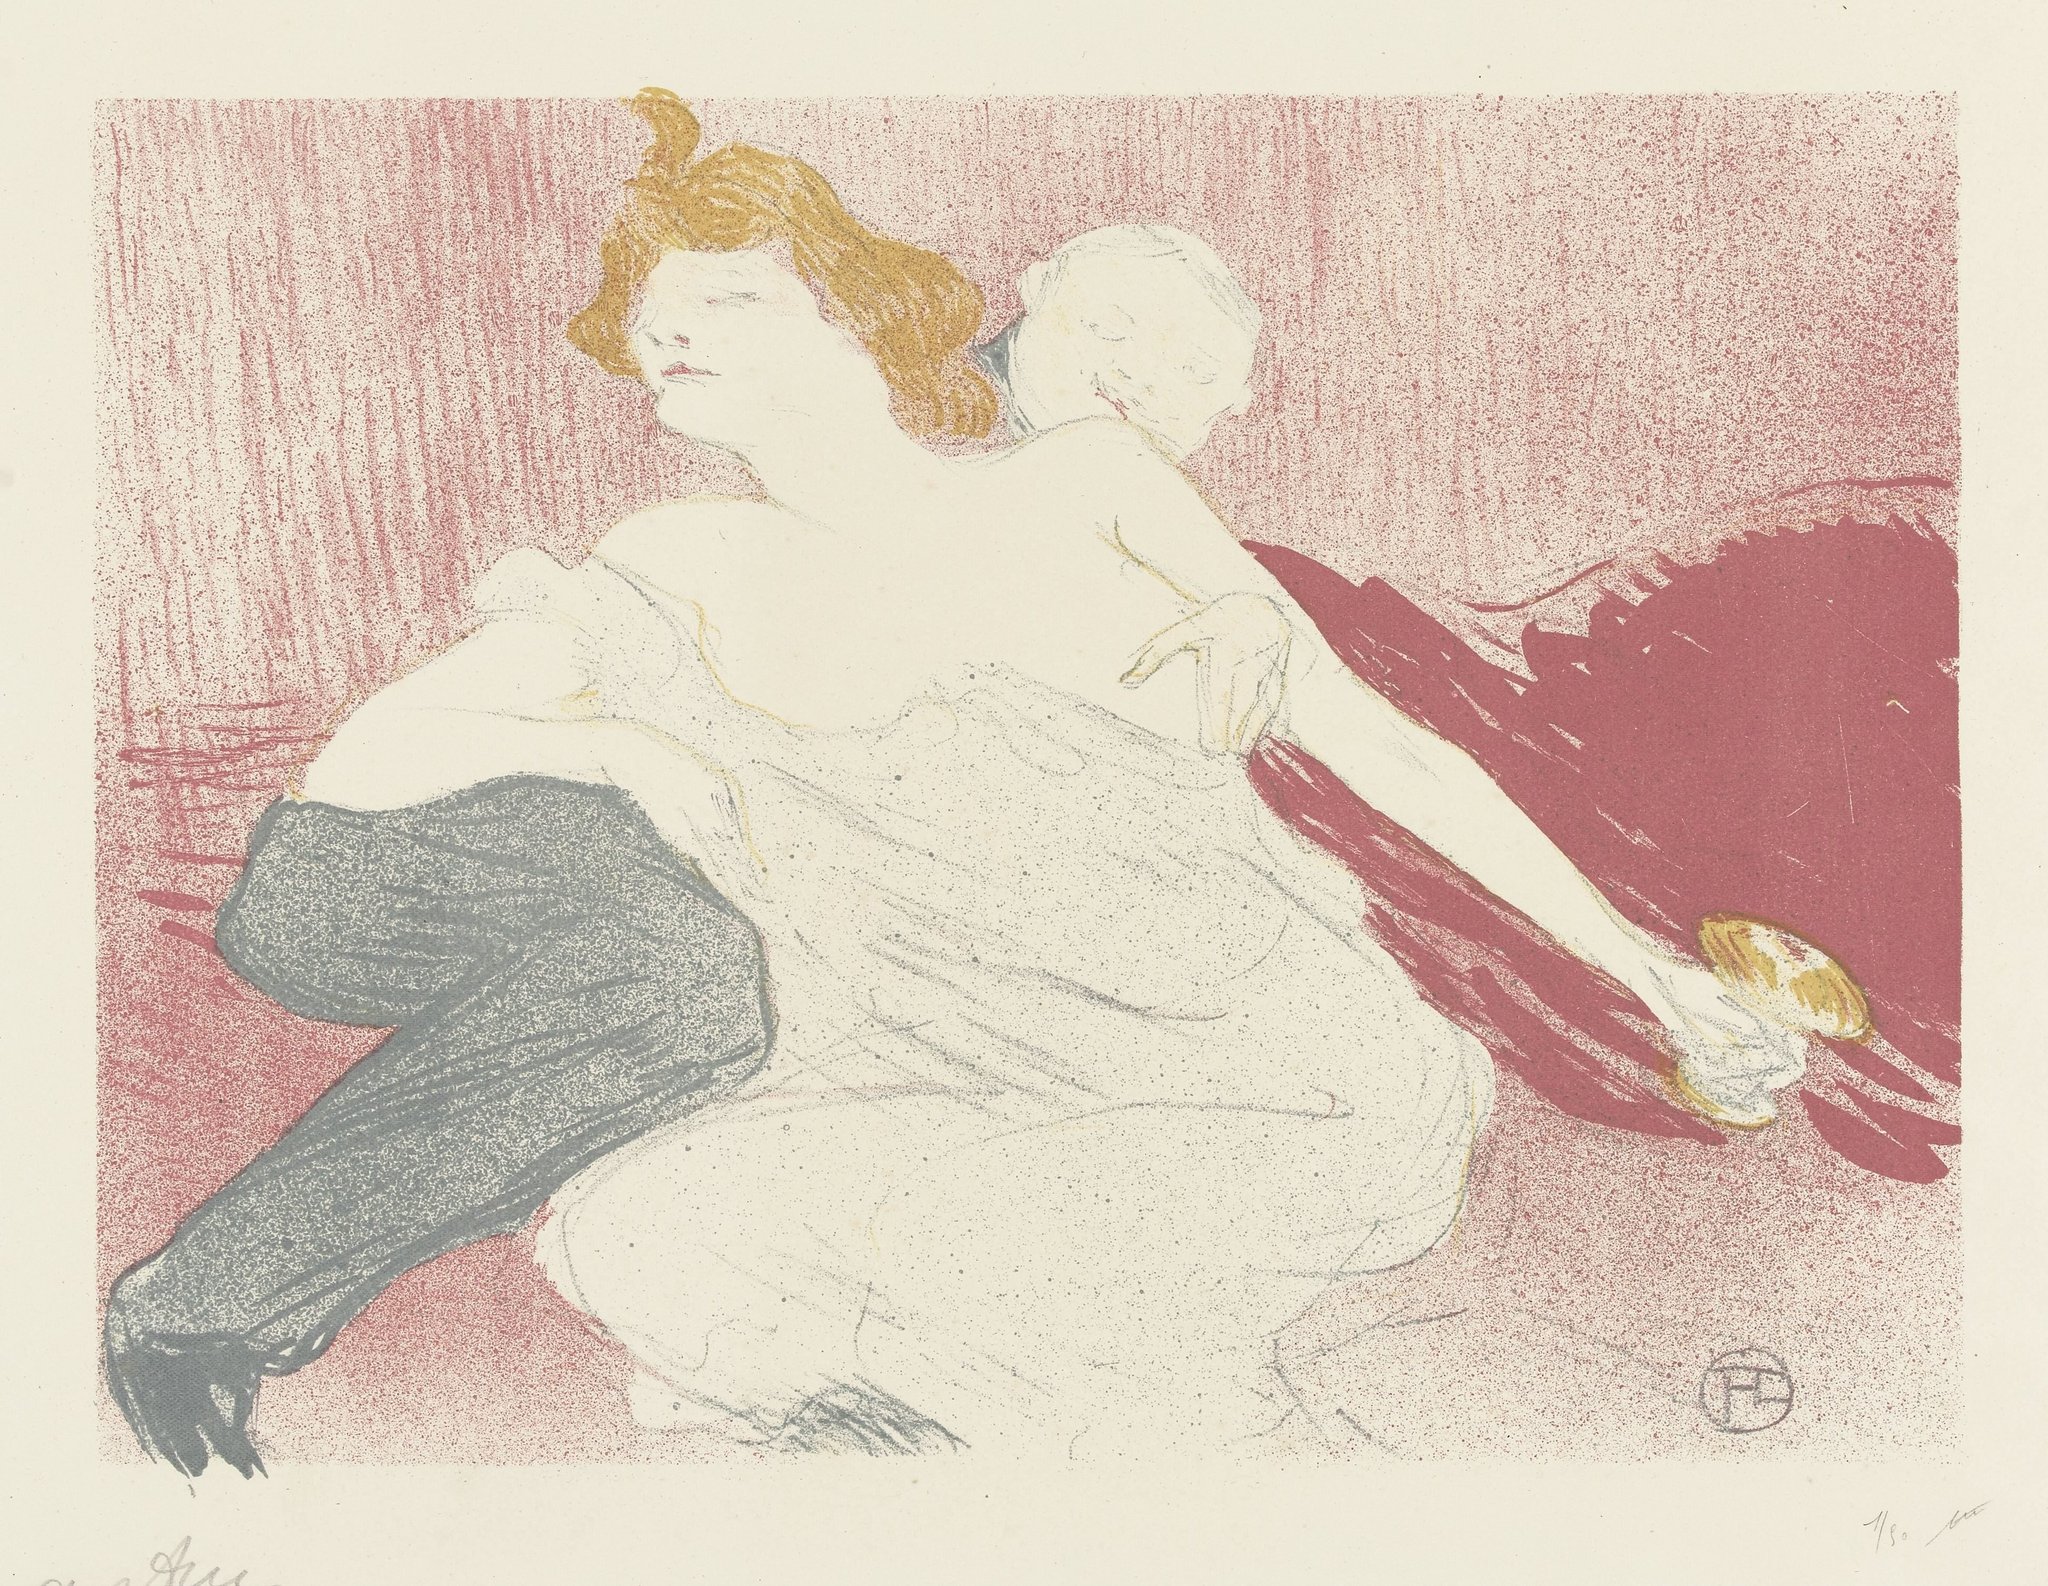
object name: print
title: Débauche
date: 1896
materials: paper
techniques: printing, lithograph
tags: artist, lovers; courting, flirting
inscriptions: collector's mark: Lugt 2760, collector's mark: Lugt 2228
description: Ontwerp voor omslag Catalogue d'Affiches artistique met liggende man en halfnaakte vrouw als geliefden. De man kan geïdentificeerd worden als de schilder Maxime Dethomas.